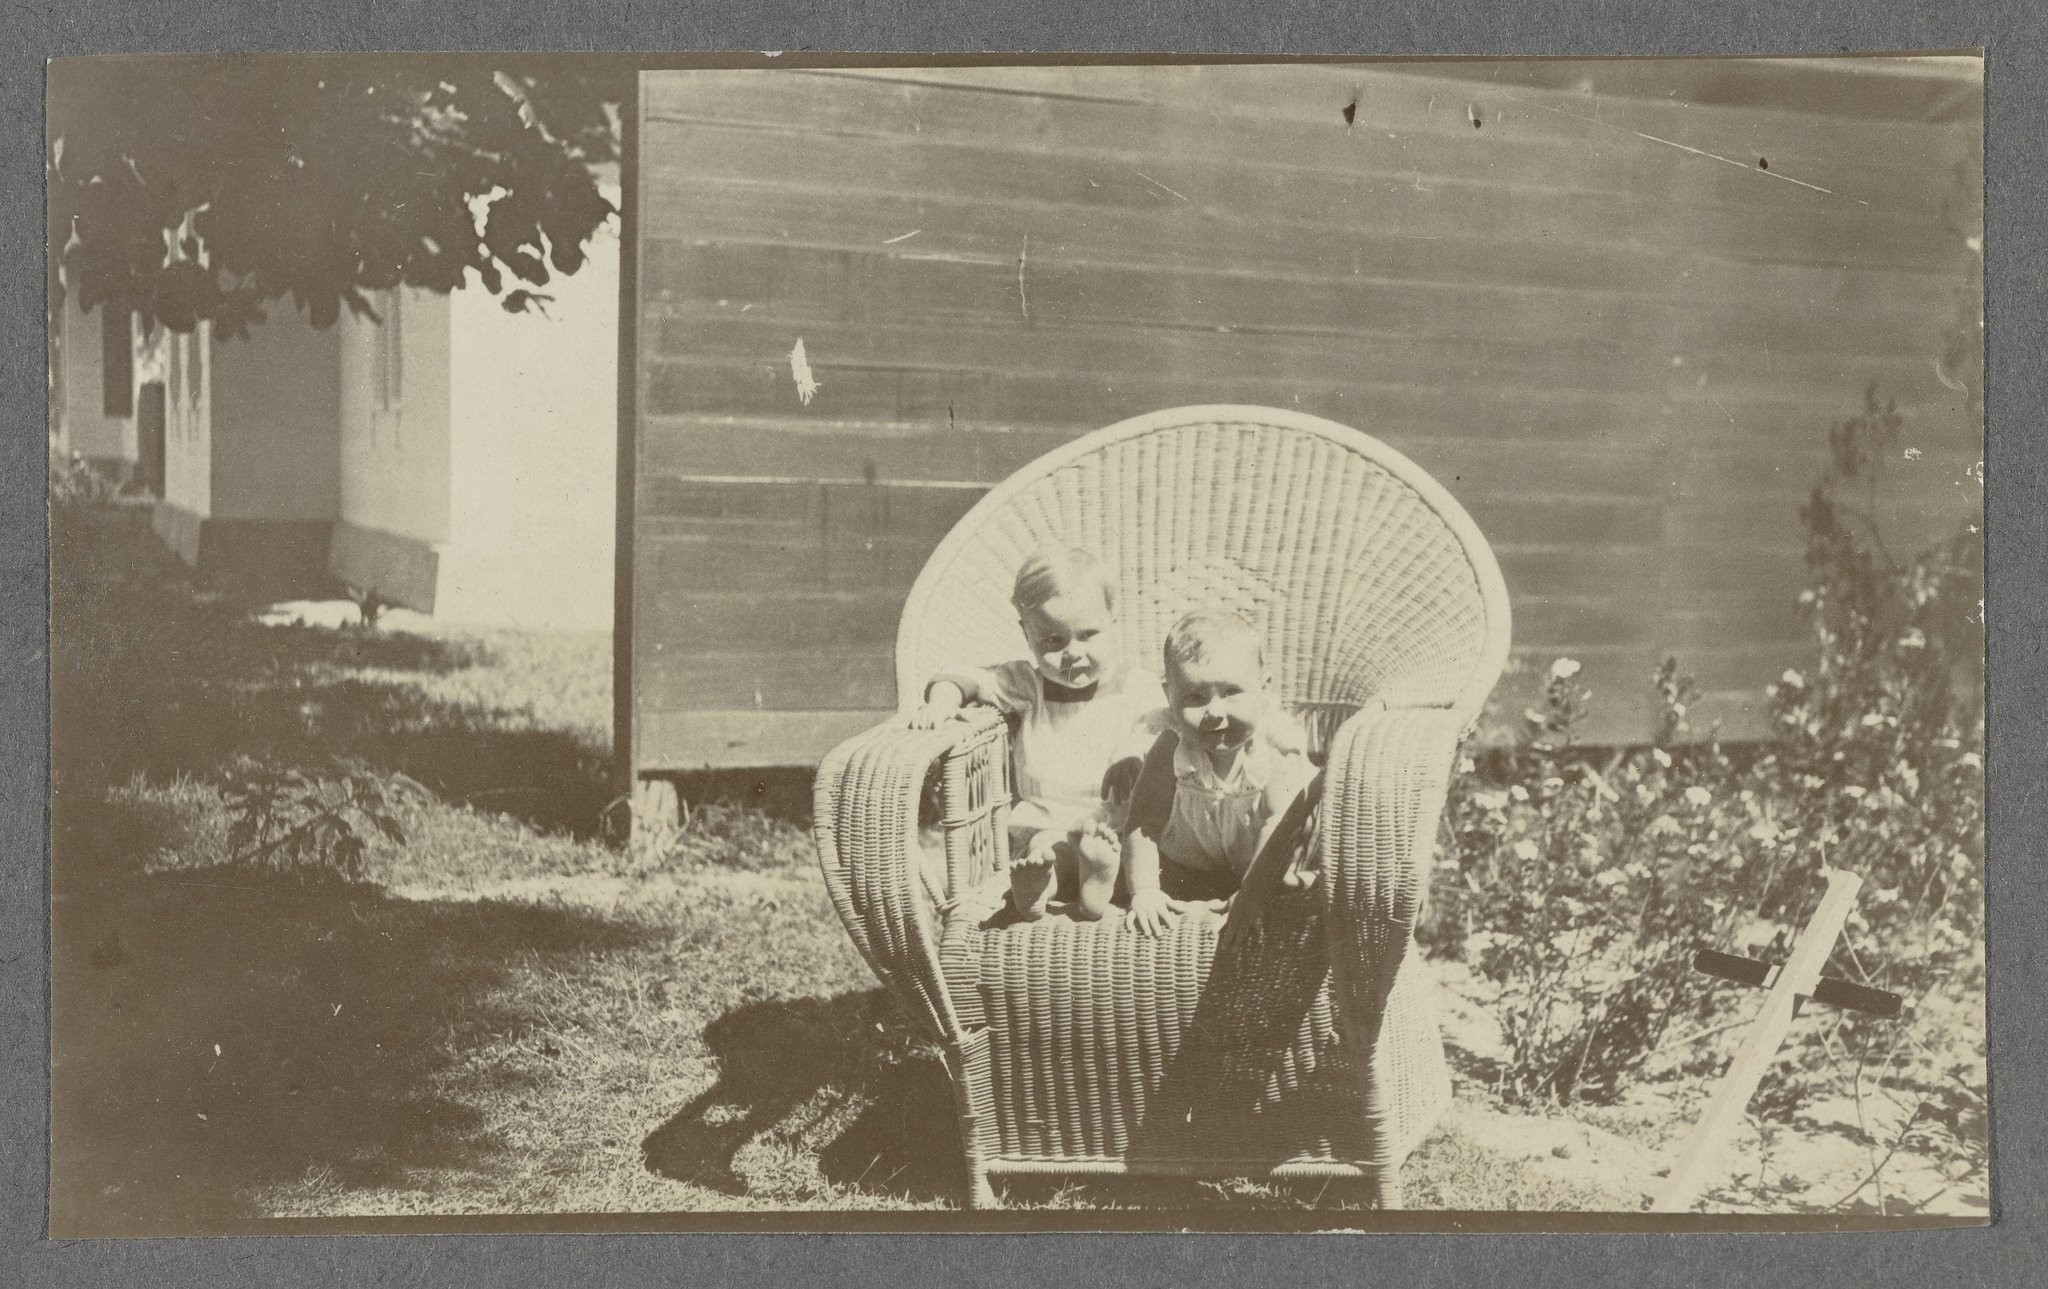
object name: photograph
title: Klaas en Tiny Kleiterp zittend in een stoel in Madjene op Celebes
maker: klaas kleiterp (i)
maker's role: arts, officier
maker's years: 1892-1943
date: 1922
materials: paper, photographic support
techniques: daylight paper print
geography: madjene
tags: garden, child, chair, brothers or sisters (second degree family relationships), dutch east indies, the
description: Onderdeel van Fotoalbum van de familie Kleiterp-Vermeulen met opnames van de kinderen Klaas en Tiny in Nederlands-Indië.